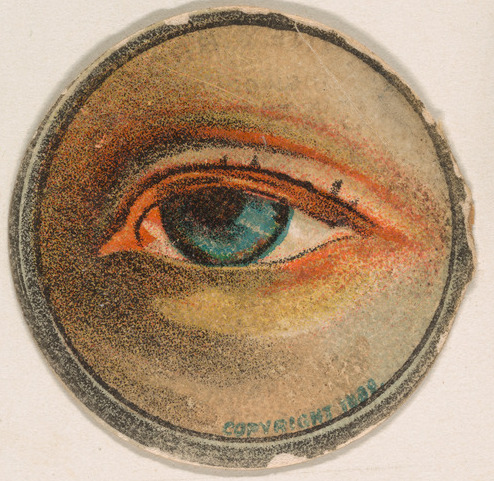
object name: print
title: Monocle and Eye (blue), from Jocular Ocular series (N221) issued by Kinney Bros.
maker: kinney brothers tobacco company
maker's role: publisher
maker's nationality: american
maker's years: 1869-2011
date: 1889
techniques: color lithograph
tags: eyes